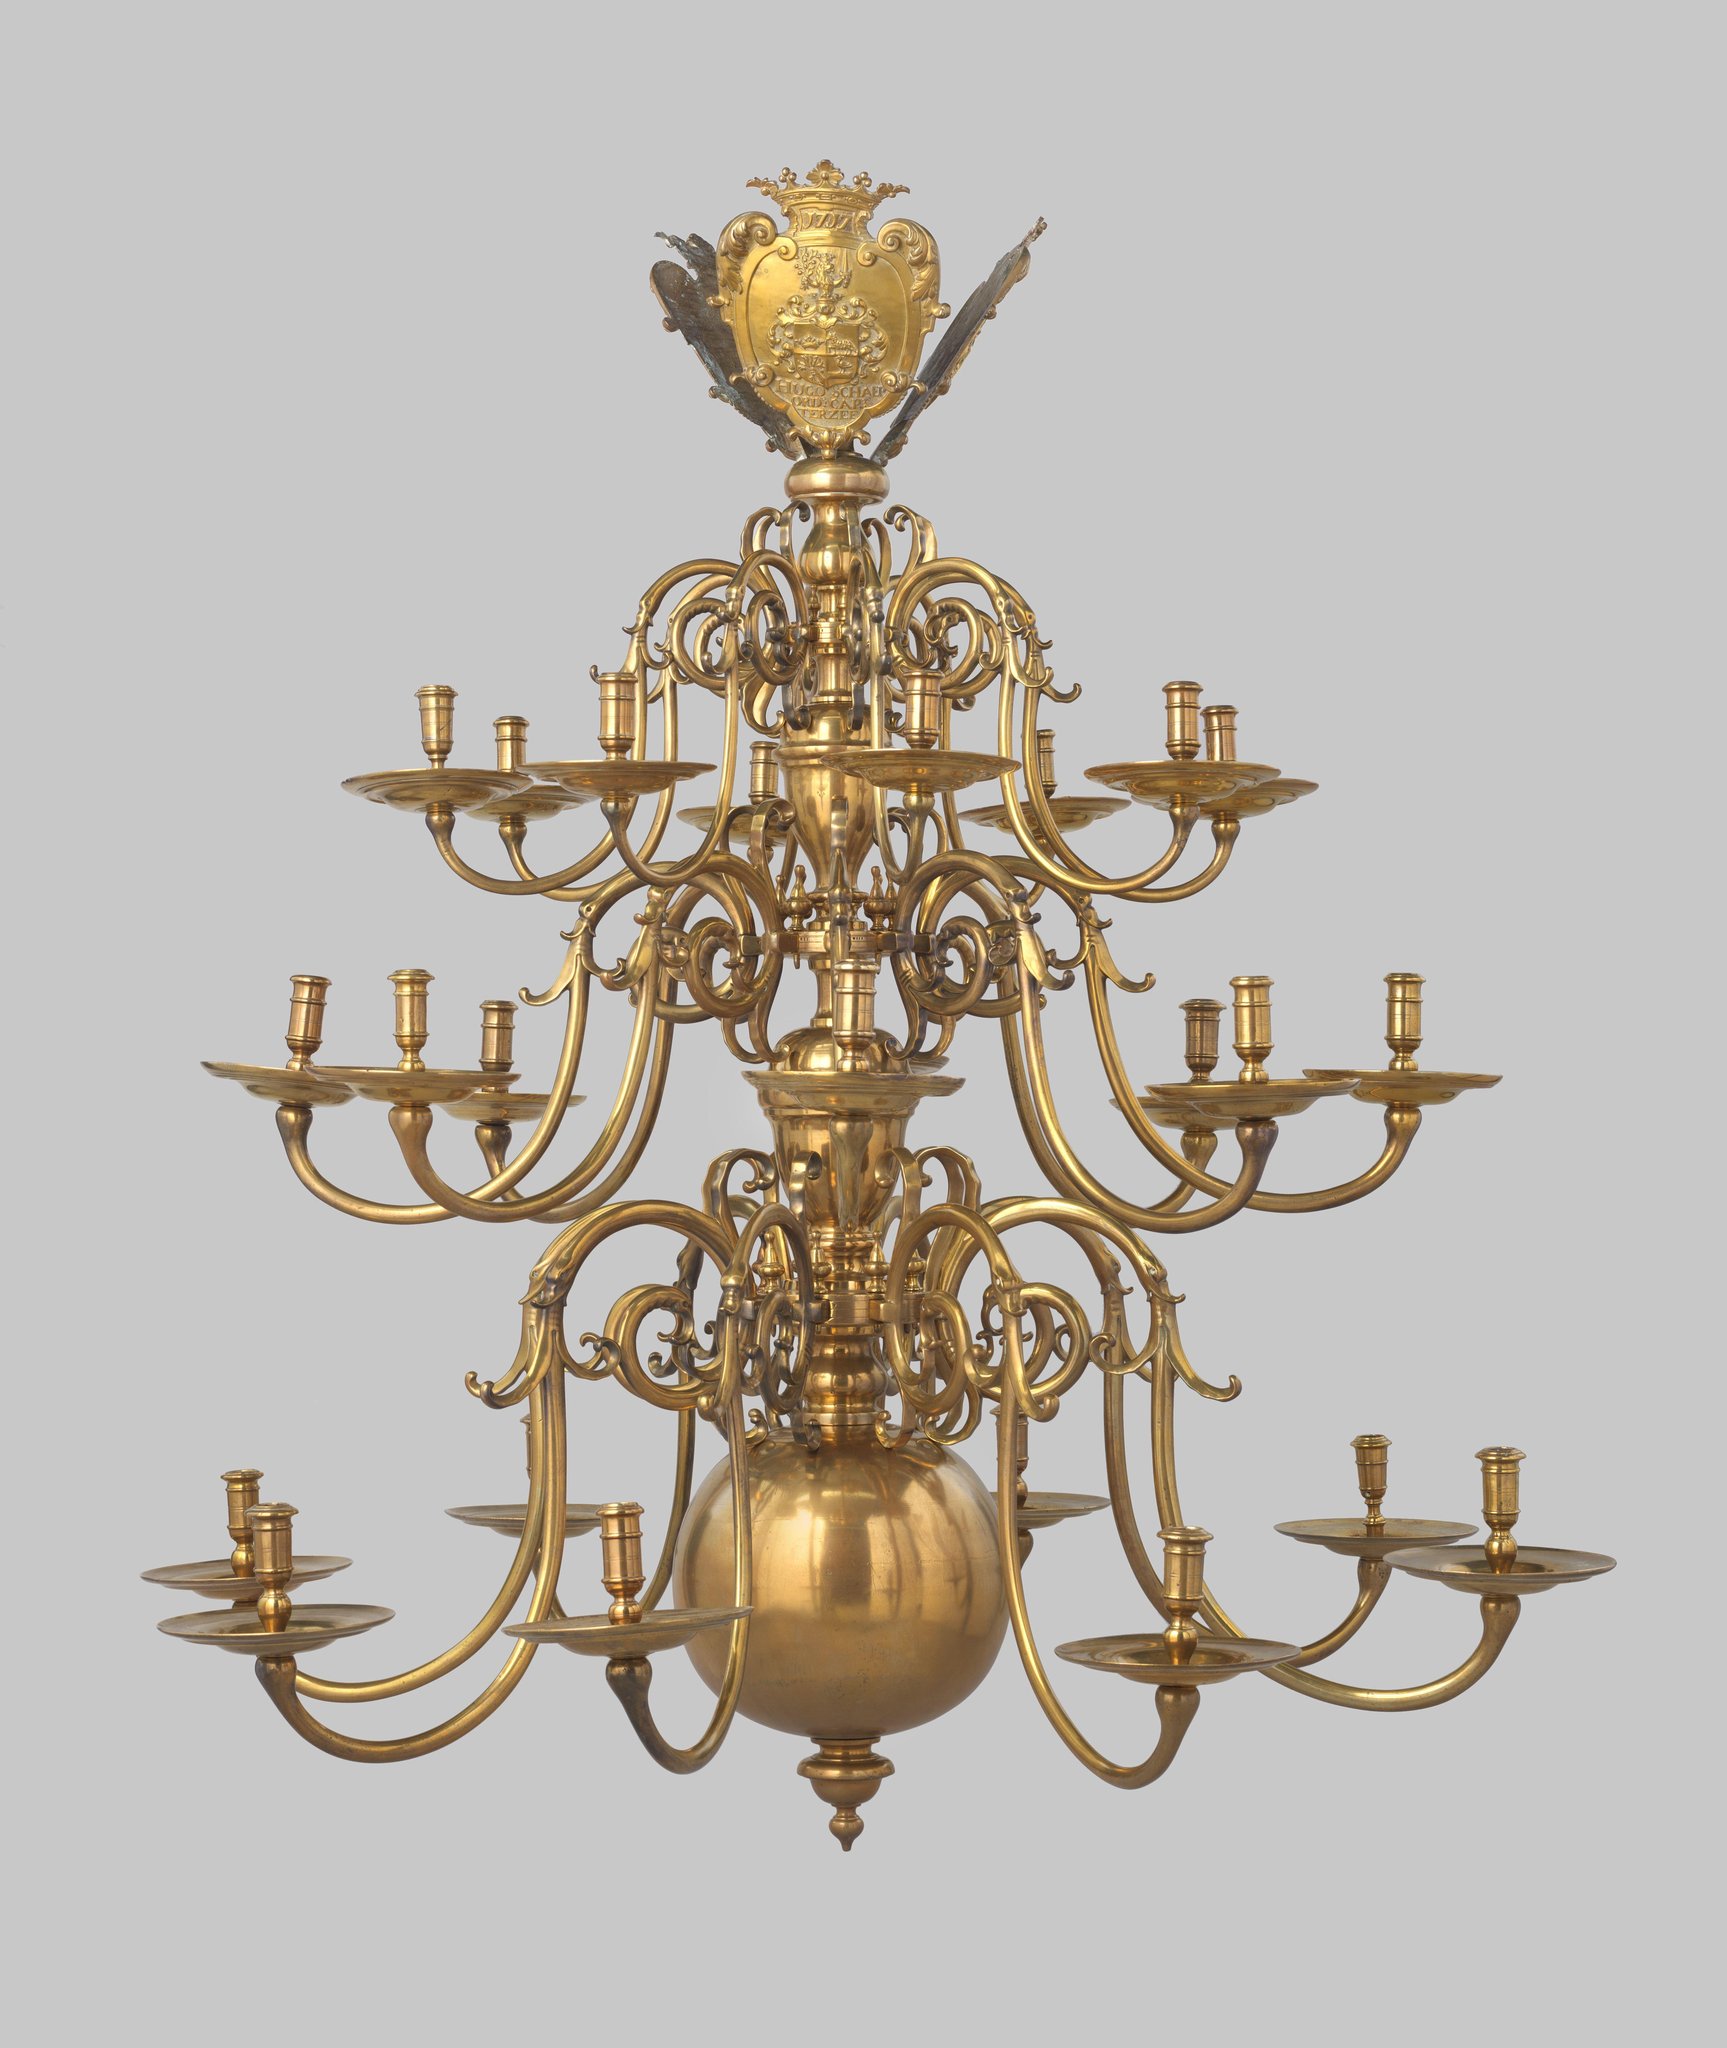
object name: chandelier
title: Arm van een kaarsenkroon in drie hoogten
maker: Anonymous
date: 1717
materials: brass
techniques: casting, screwed, turning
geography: amsterdam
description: De S-vormige arm is aan de stamzijde voorzien van een nok om deze met een pin in de standring te kunnen vastzetten. Bij de stam is de arm op het eind en naar het midden toe versierd met twee gestileerde dolfijnenkoppen en met krullen, waarvan de vorm aan het kwabornament is ontleend. Naar buiten toe eindigt de arm in een verdikking, waarin een van een schroefdraad voorzien gat is aangebracht ter bevestiging van de kaarsenhouder op de vetvanger. De arm is met behulp van hetzelfde model gegoten als de overige armen van de krans. De kaarsenhouder is cylindervormig met geprofileerd uitstekende rand en met een balustervoet, welke overgaat in een van een schroefdraad voorzien eind, waarin onderaan het centergat. De vetvanger is aan de bovenkant naar het midden toe één keer verdiept. Aan de onderkant is deze rond het gat in het enigszins bolvormige midden geprofileerd en is de rand geribd. De vetvanger met behulp van hetzelfde model gegoten als de overige vetvangers van deze krans. De pin is voorzien van een vaasvormige knop. Dit is de tweede arm van de onderste standring, genummerd op de nok met het cijfer II.